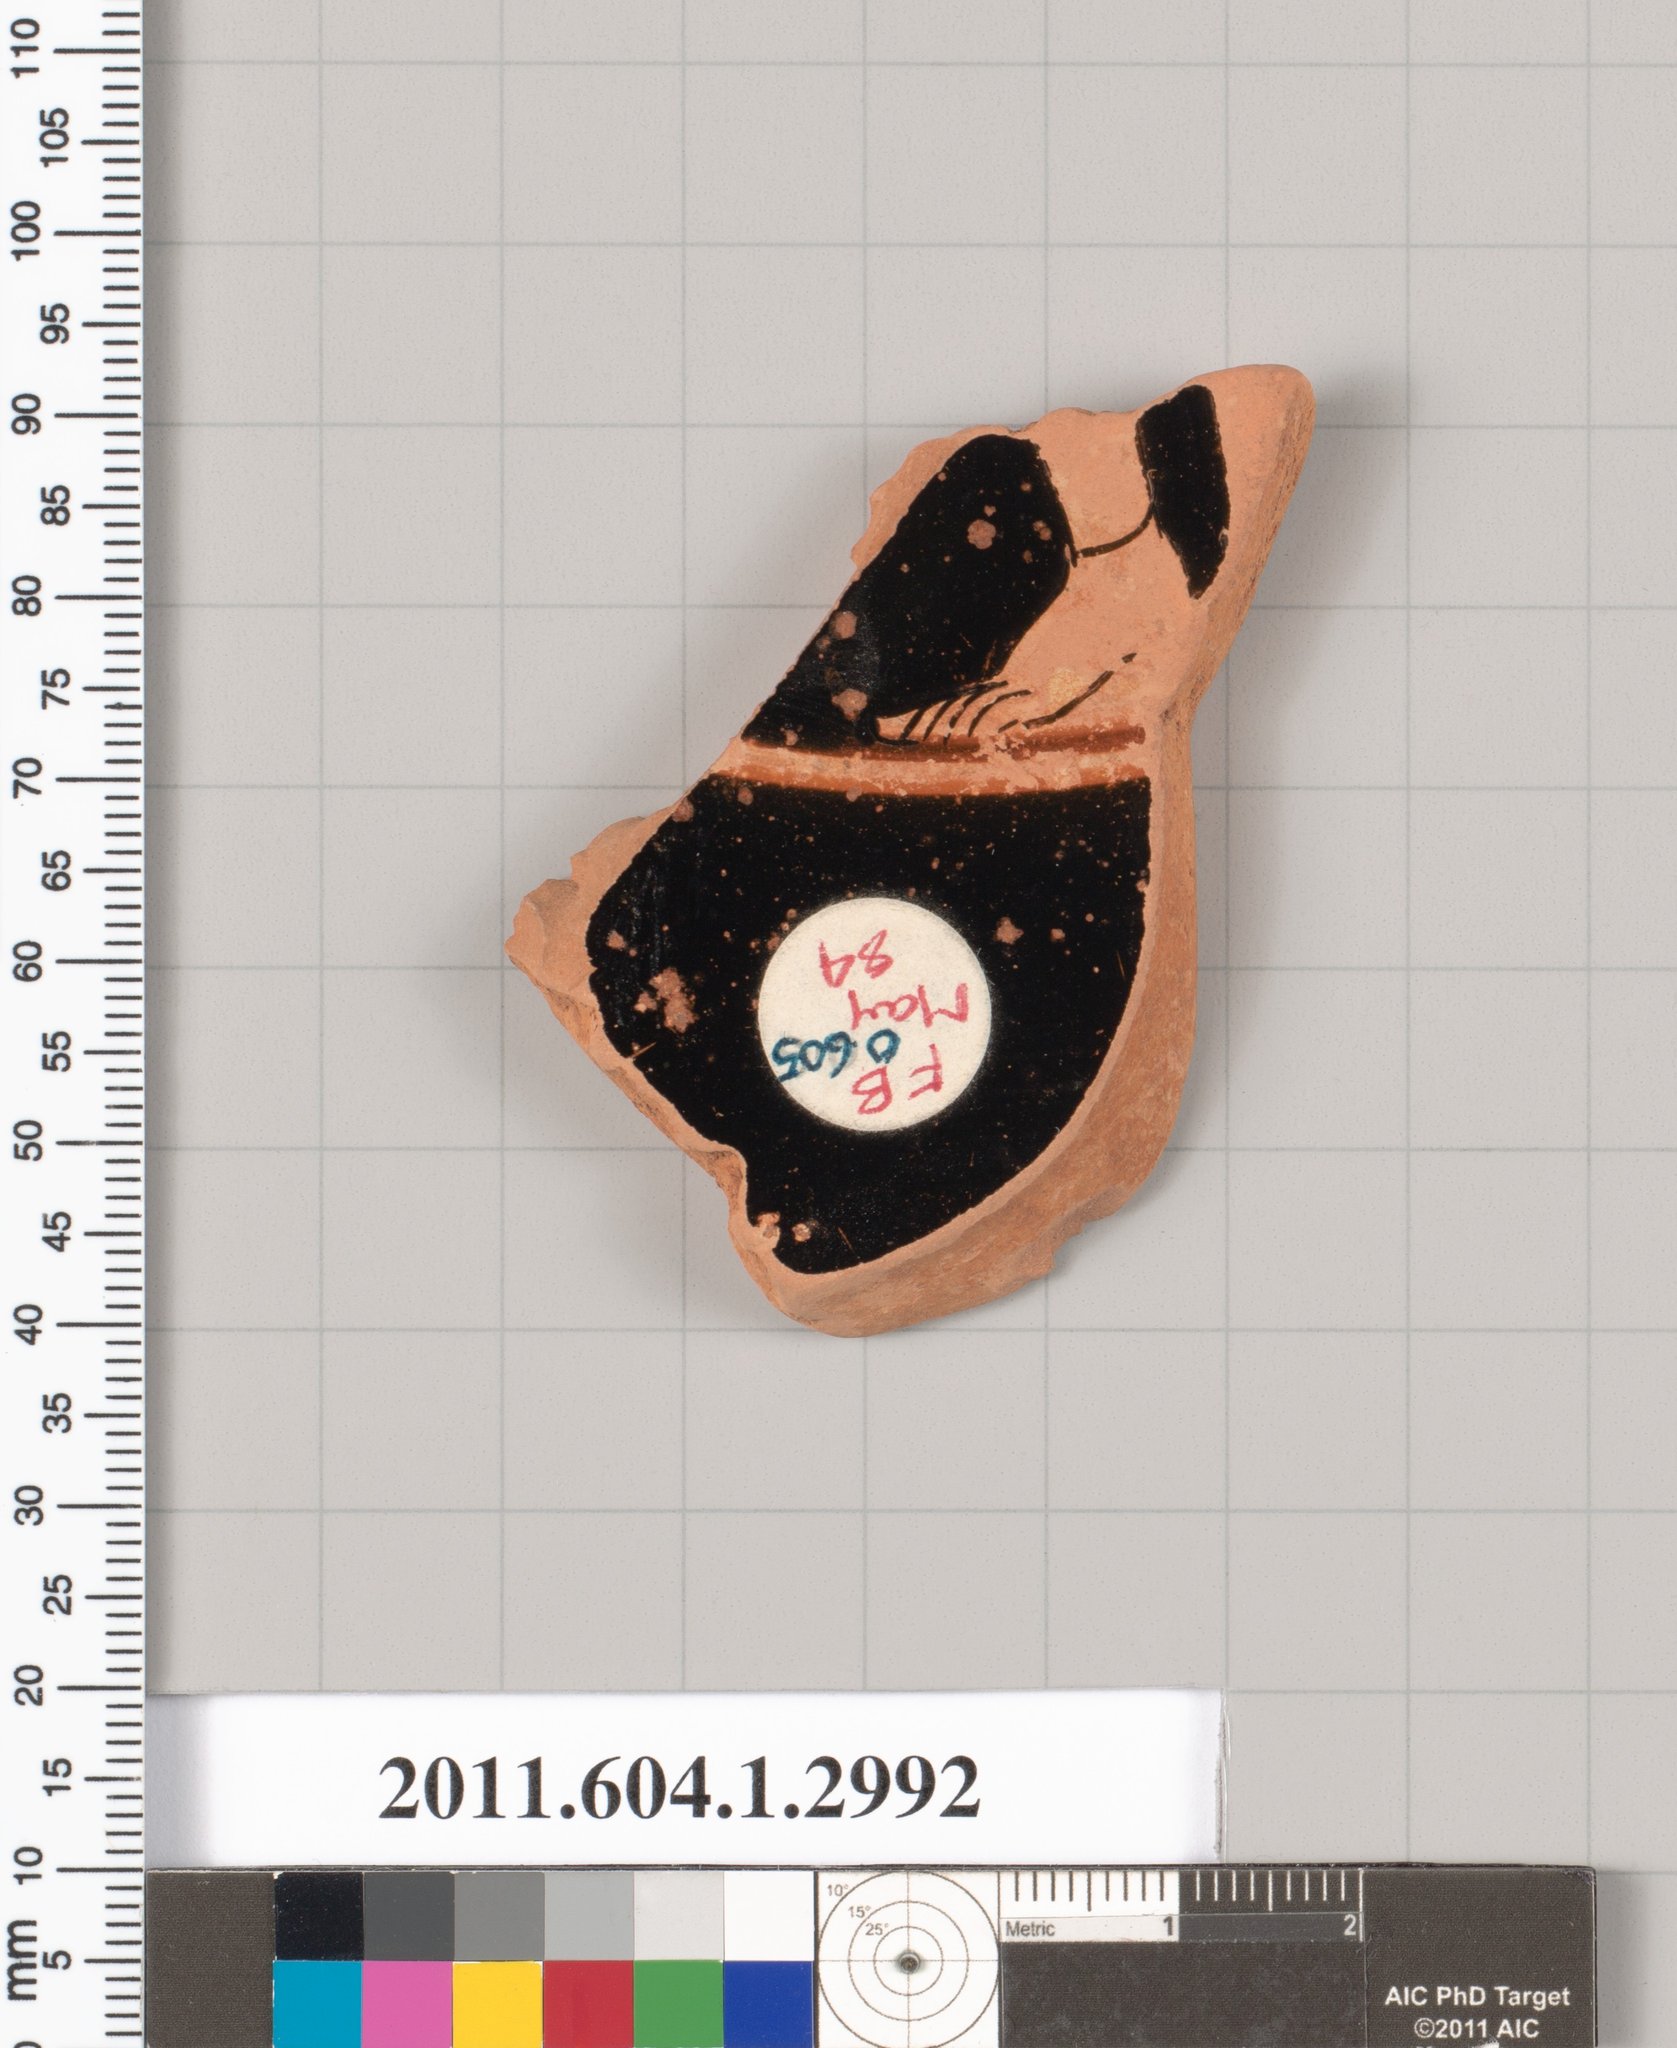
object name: kylix fragment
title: Terracotta fragment of a kylix (drinking cup)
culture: greek, attic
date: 475-451 BCE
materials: terracotta